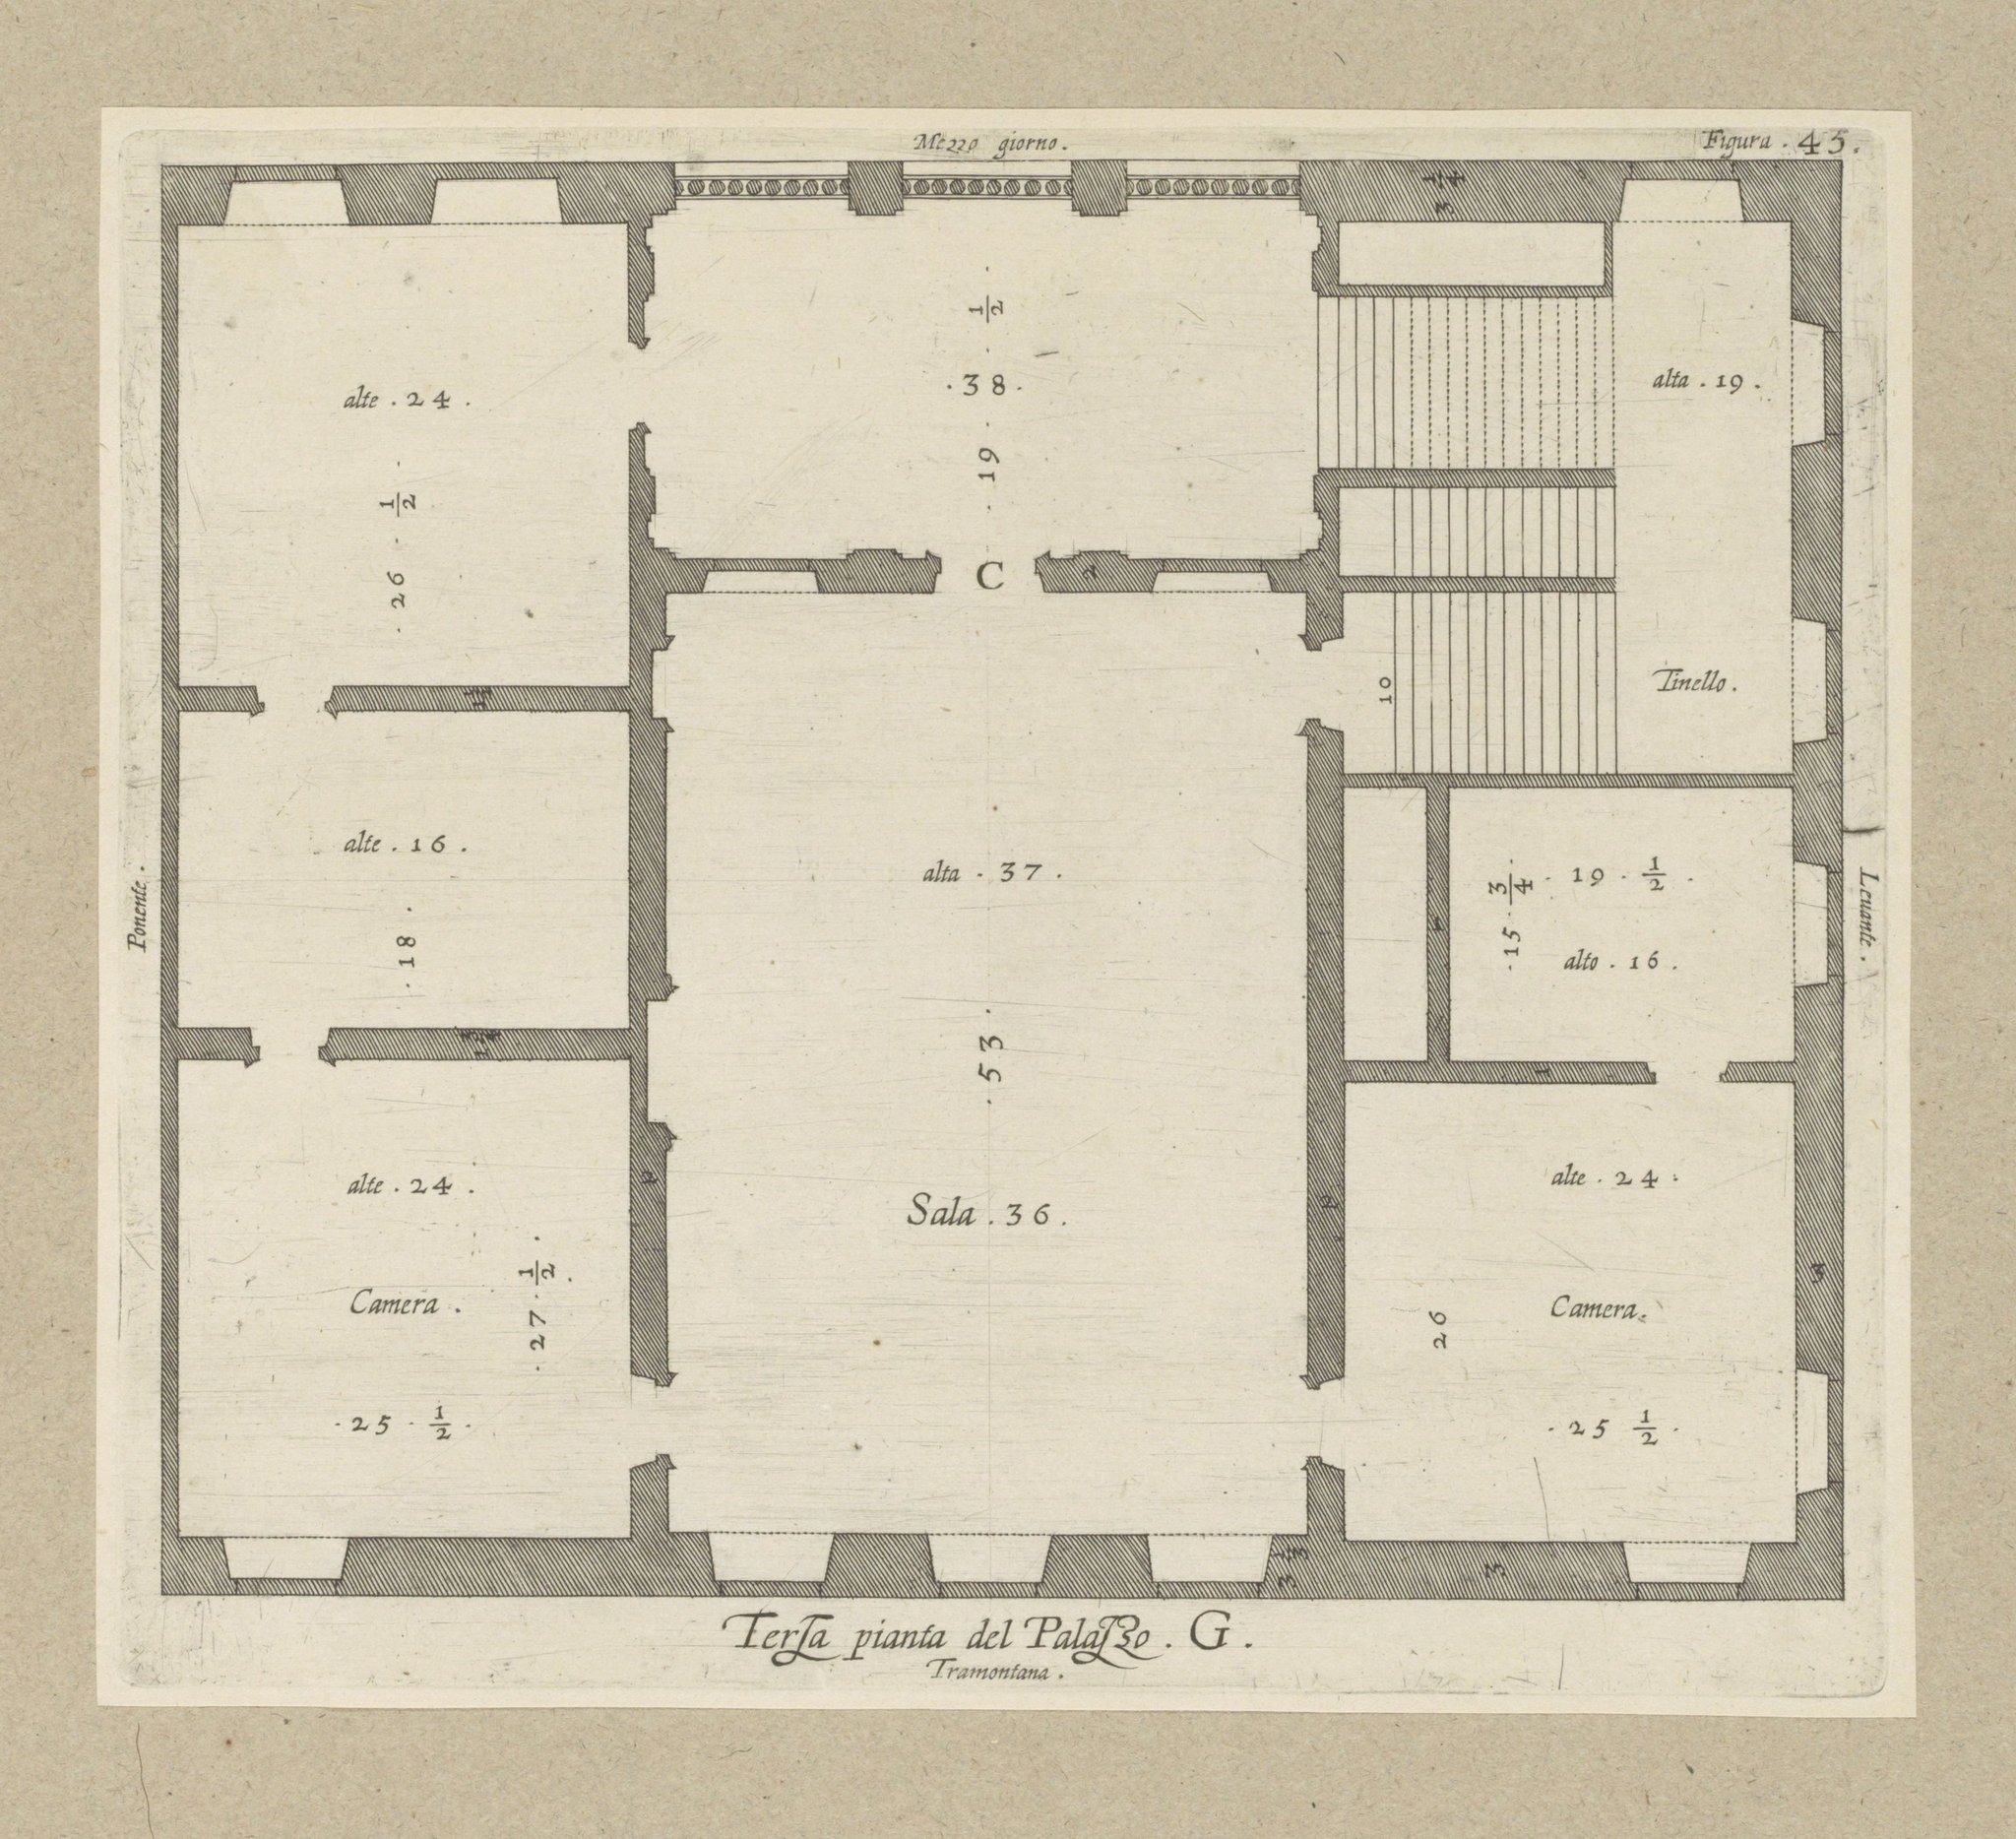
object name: print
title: Terza pianta del Palazzo. G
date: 1622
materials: paper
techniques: engraving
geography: antwerp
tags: hôtel, i.e. small palace in city - aa - civic architecture: inside, plan ~ architecture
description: Deze prent maakt deel uit van een album.